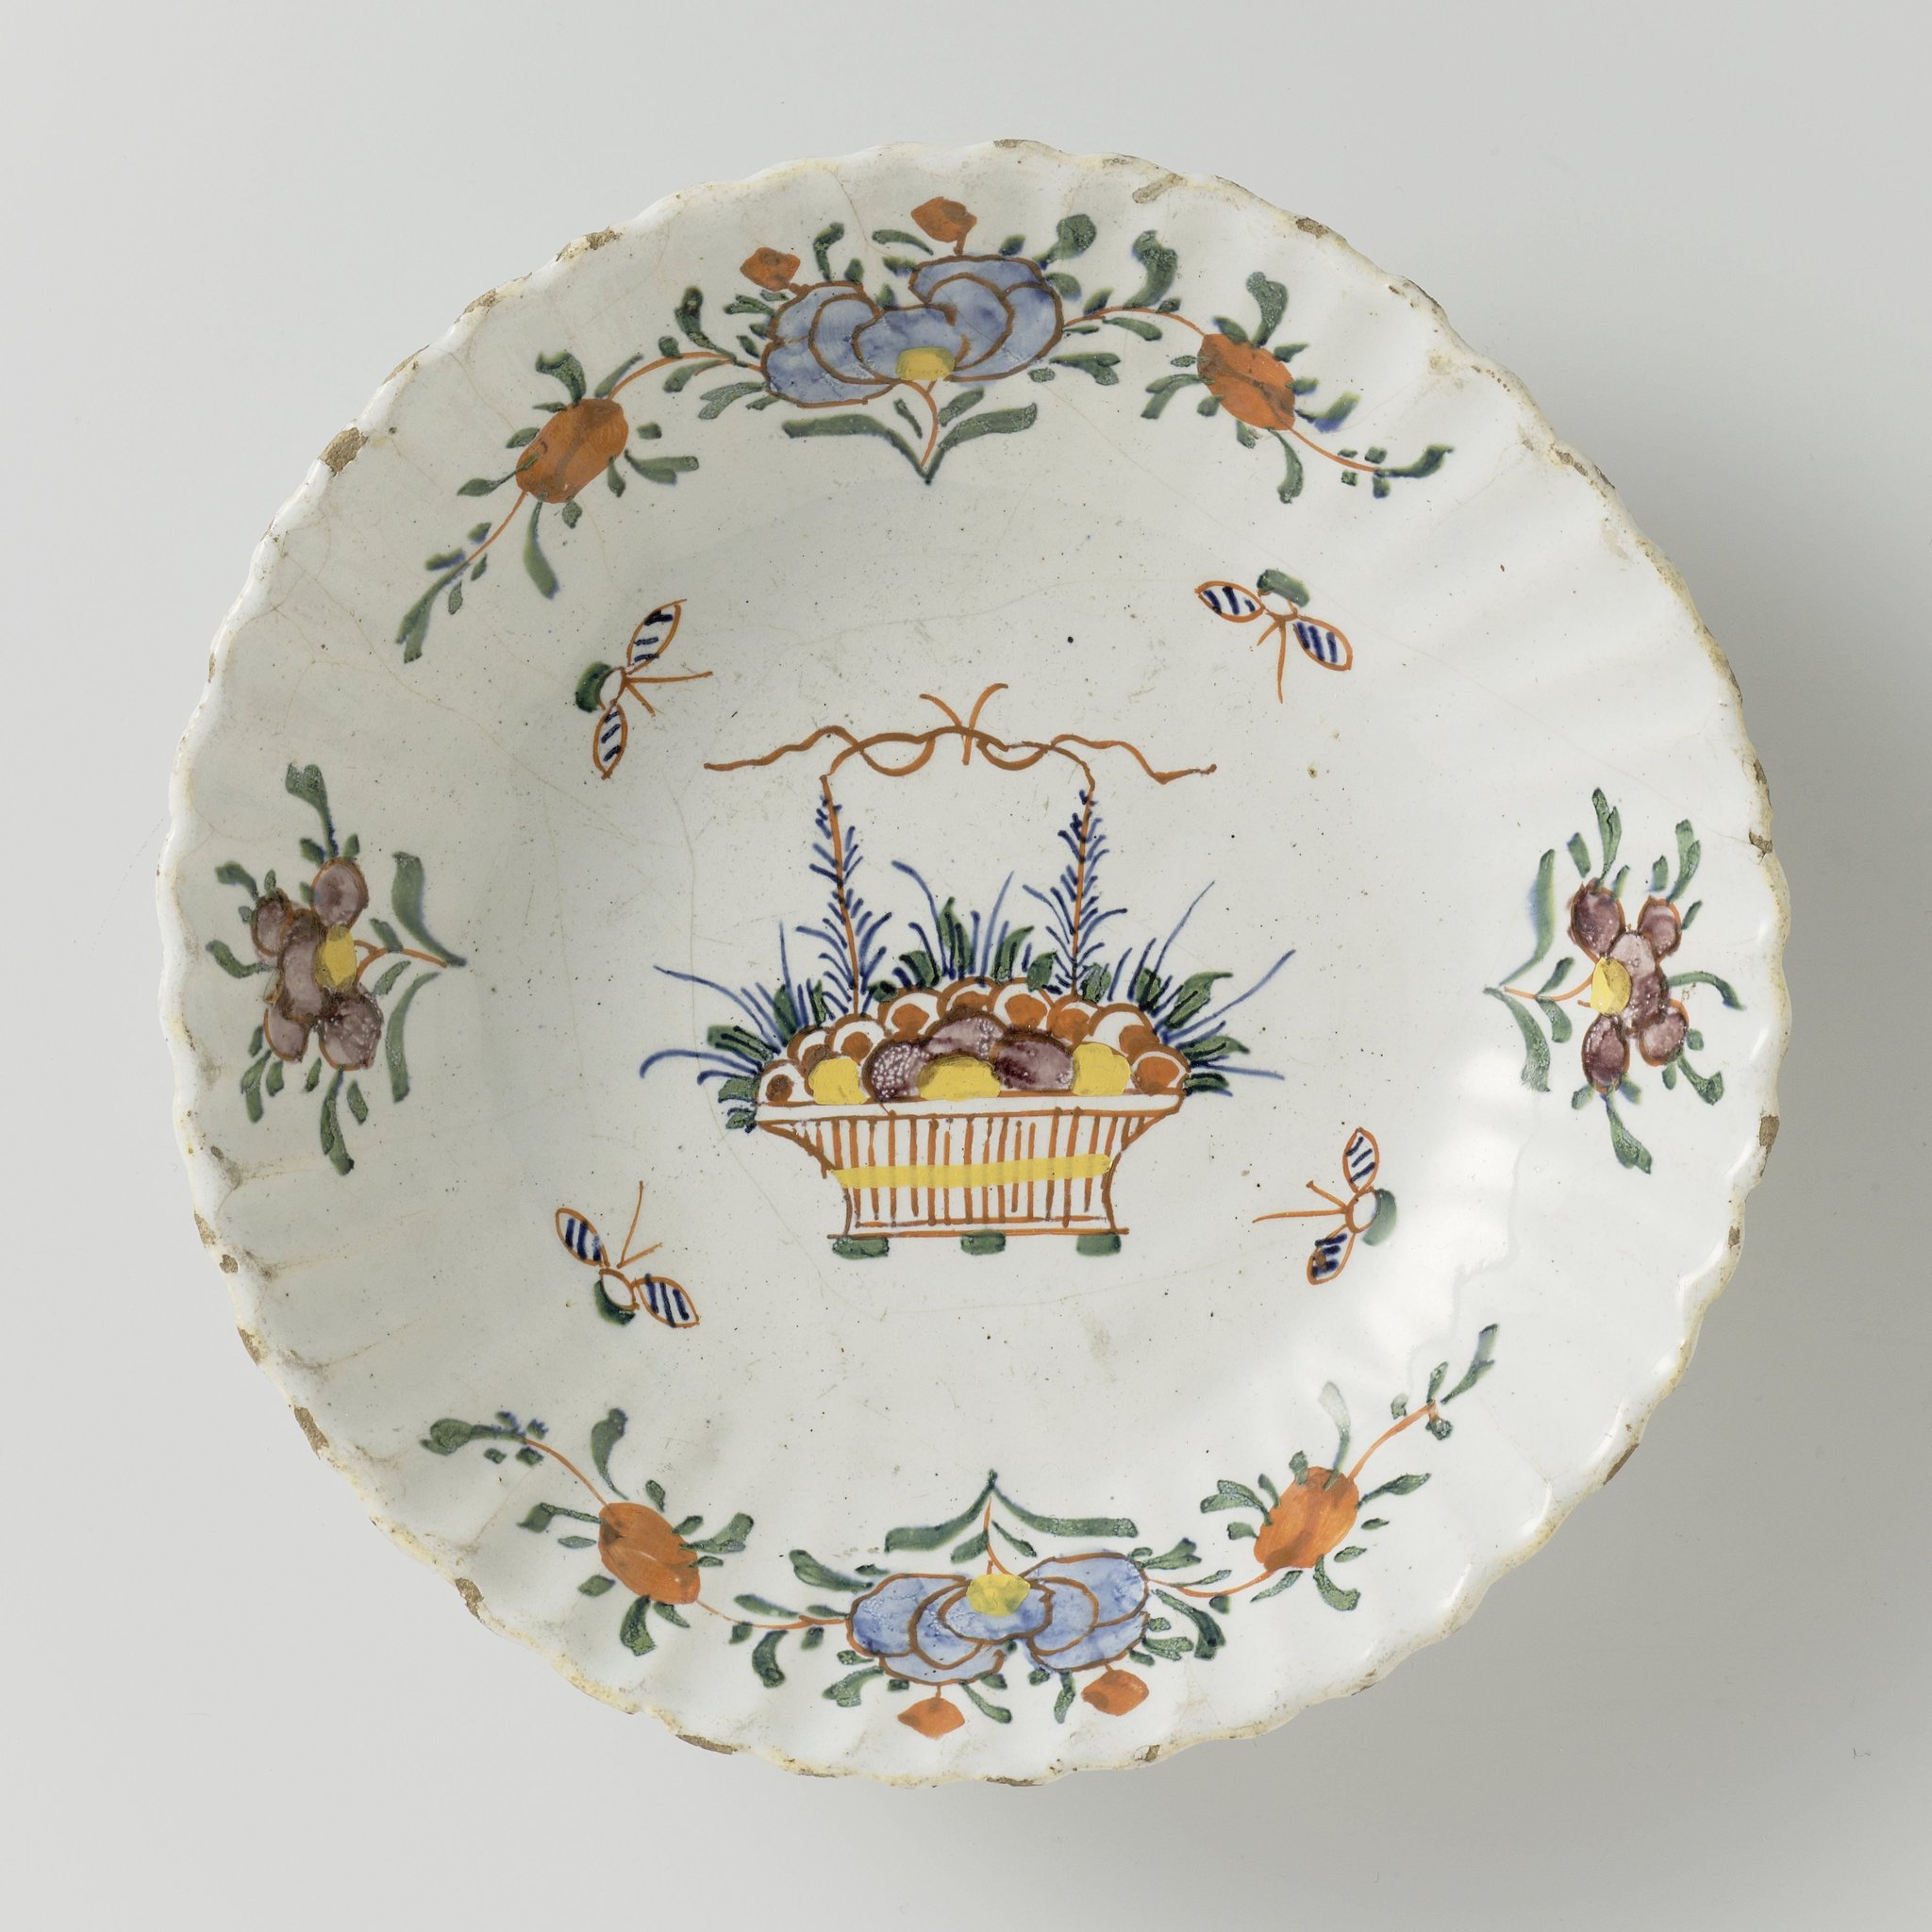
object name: platter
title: Veelkleurig beschilderde schotel van faïence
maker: Anonymous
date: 1740-1775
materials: faience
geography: delft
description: Schotel van faience. Veelkleurig beschilderd met een mand en bloemdecoraties.